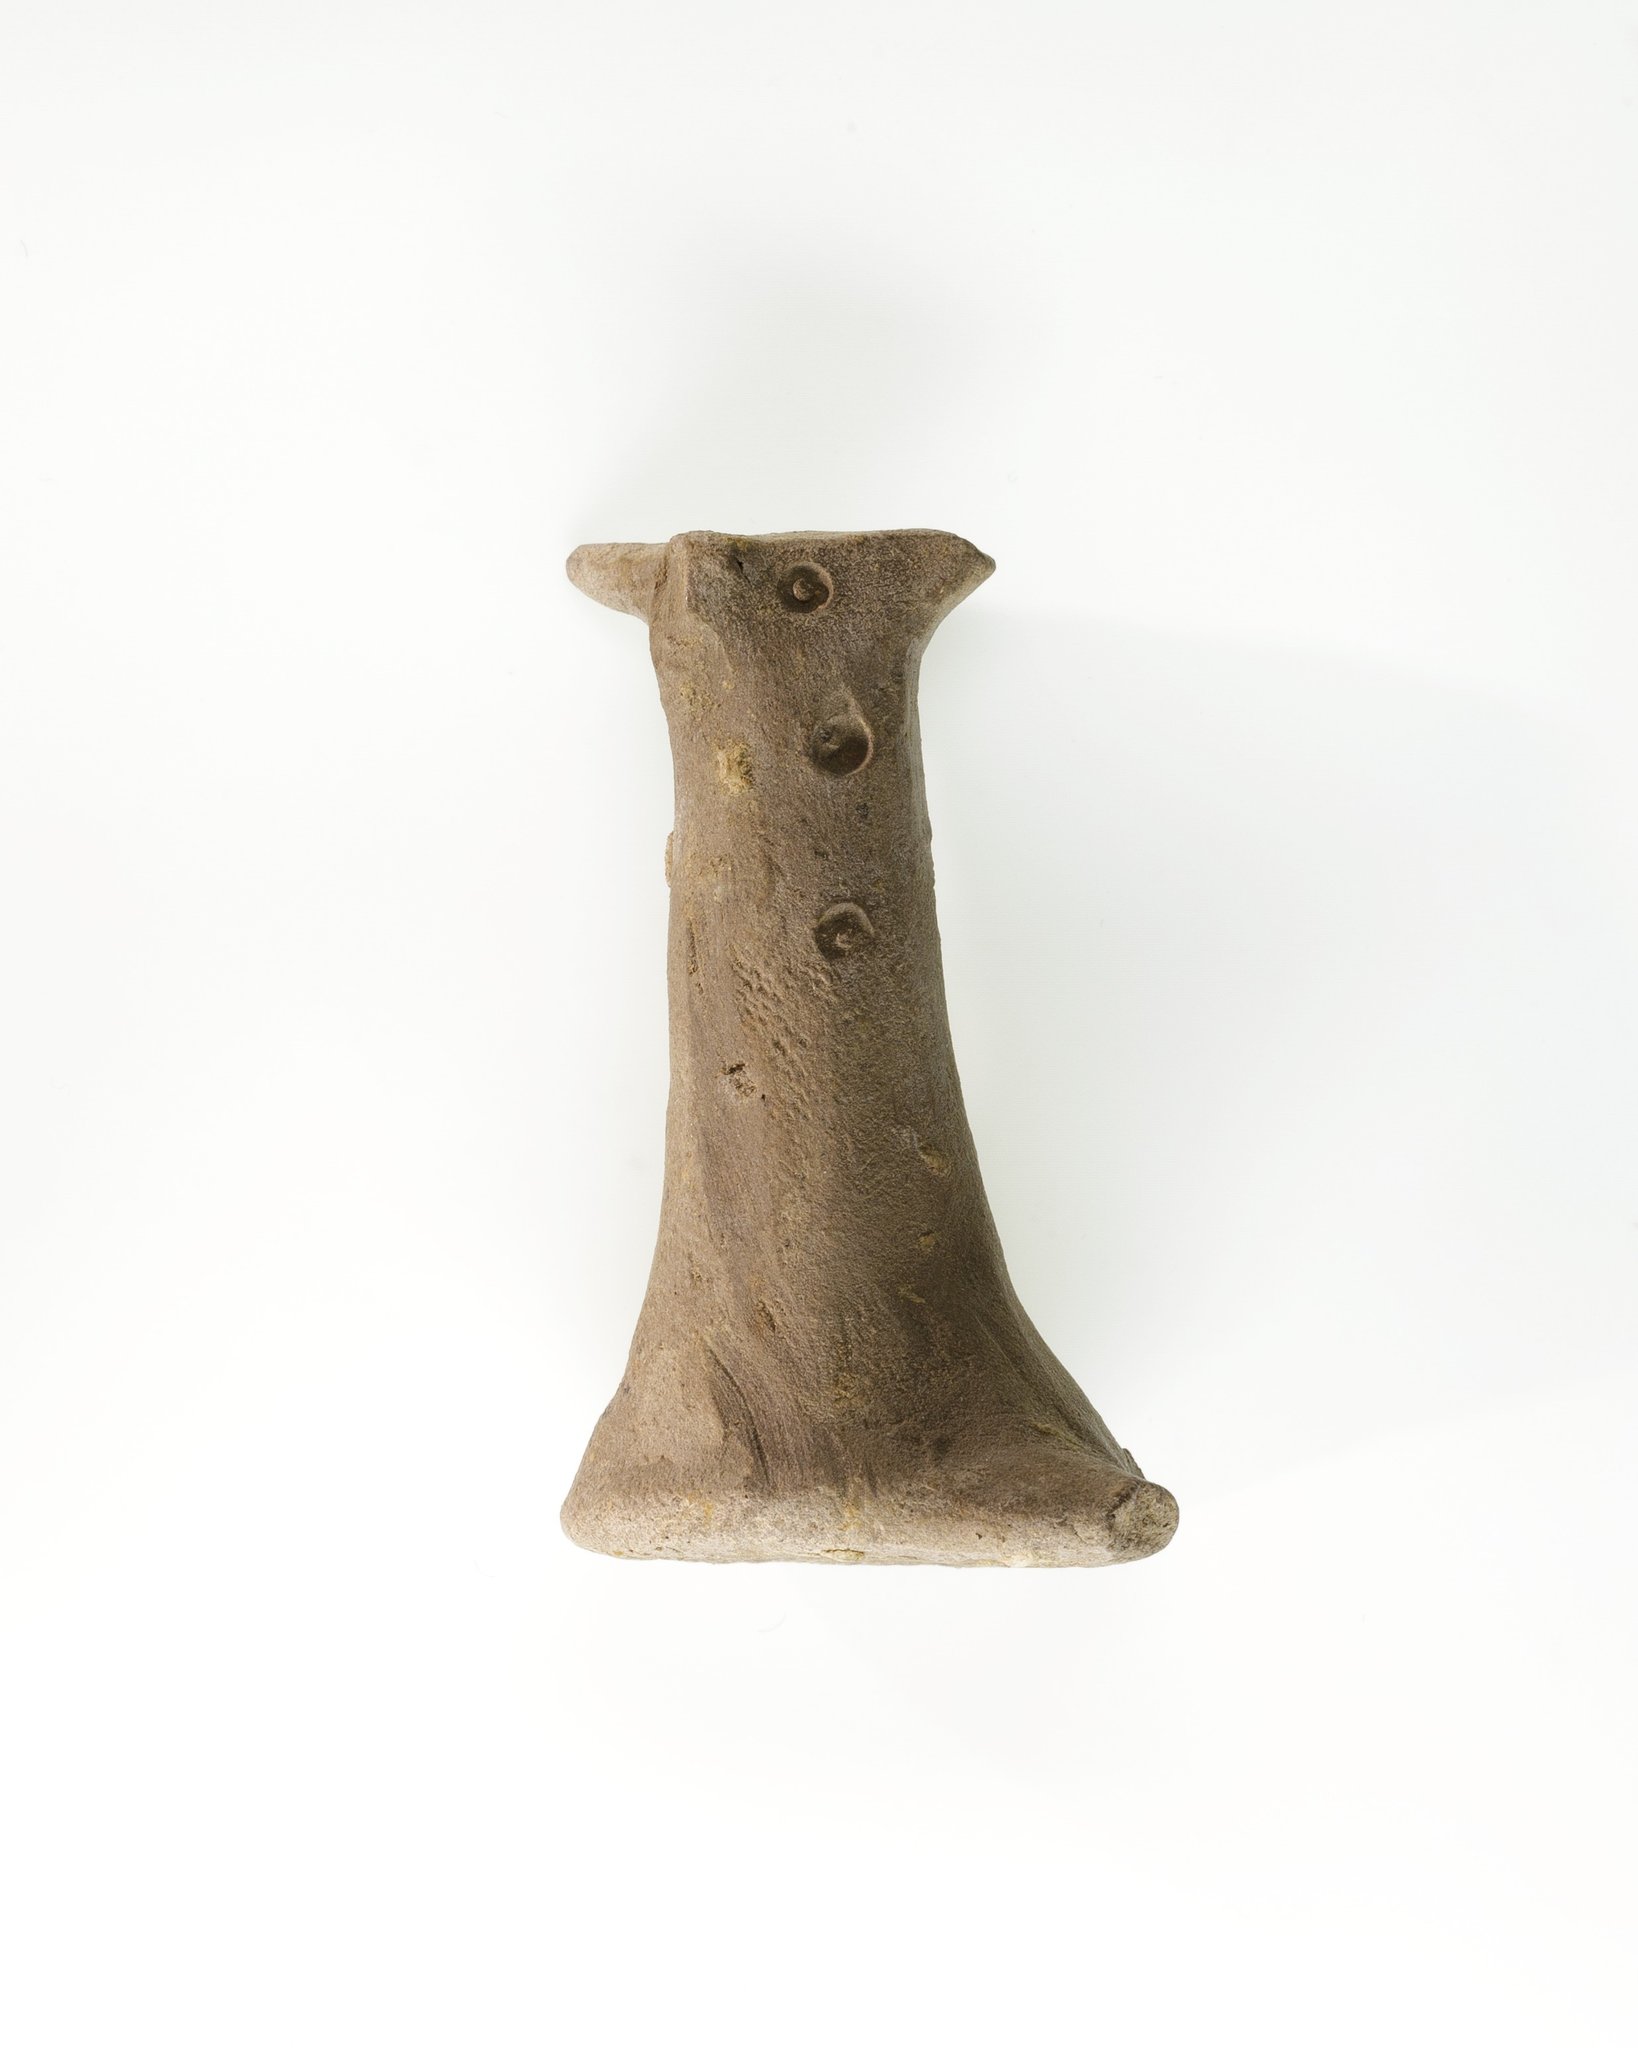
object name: animal figure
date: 1850-1750 BCE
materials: mud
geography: egypt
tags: animals